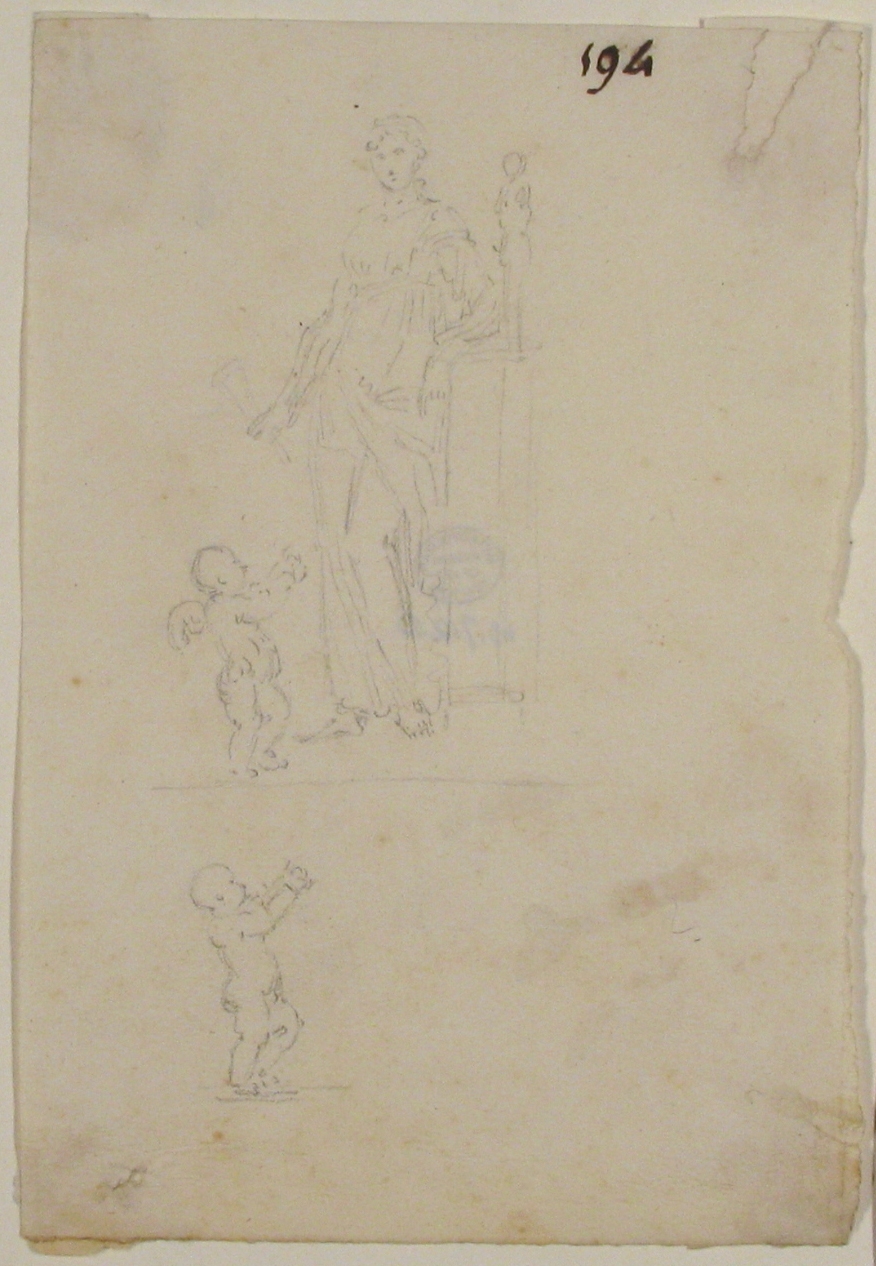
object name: drawing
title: Standing Female Figure with Cupid; Figure of Cupid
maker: anonymous, french, 18th century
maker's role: artist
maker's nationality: french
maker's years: 1700-1800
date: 1701-1800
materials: graphite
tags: women,cupid